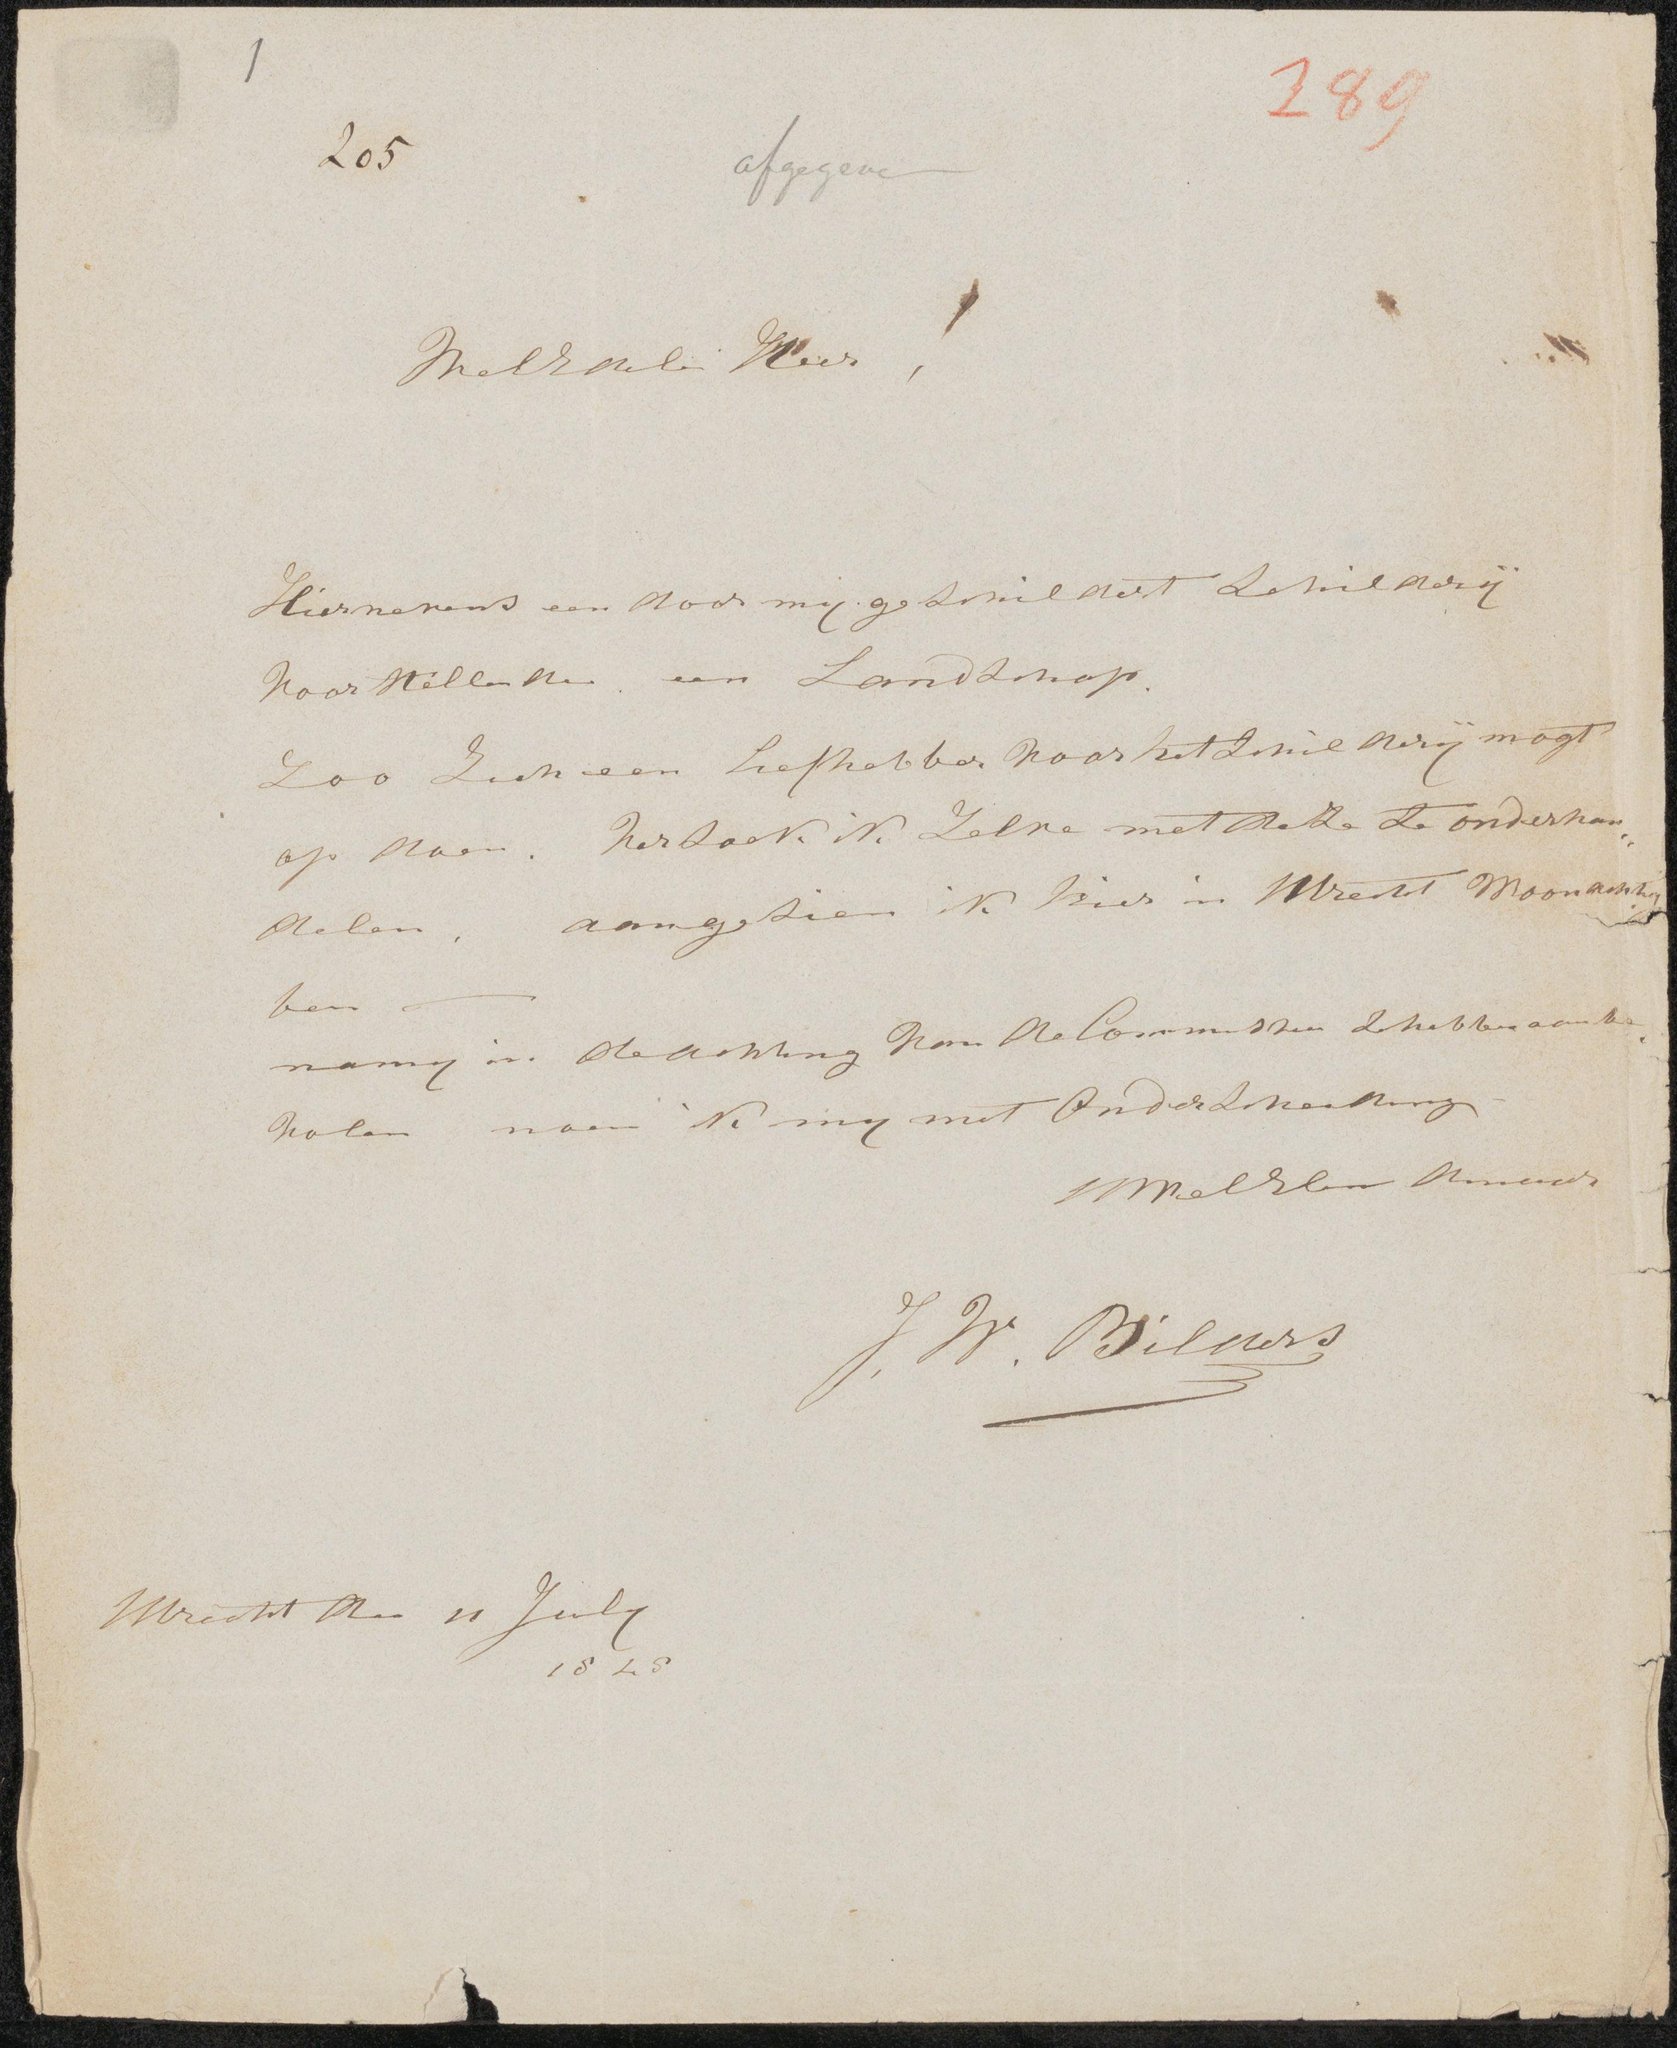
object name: letter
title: Brief aan de commissie van de Tentoonstelling van Levende Meesters in Utrecht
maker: johannes warnardus bilders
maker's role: painter, print maker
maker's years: 1811-1890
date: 1848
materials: ink, paper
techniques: pen, writing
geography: utrecht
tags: painting (including book-illumination, miniature-painting), exhibition ~ art, utrecht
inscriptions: collector's mark: Lugt 2233